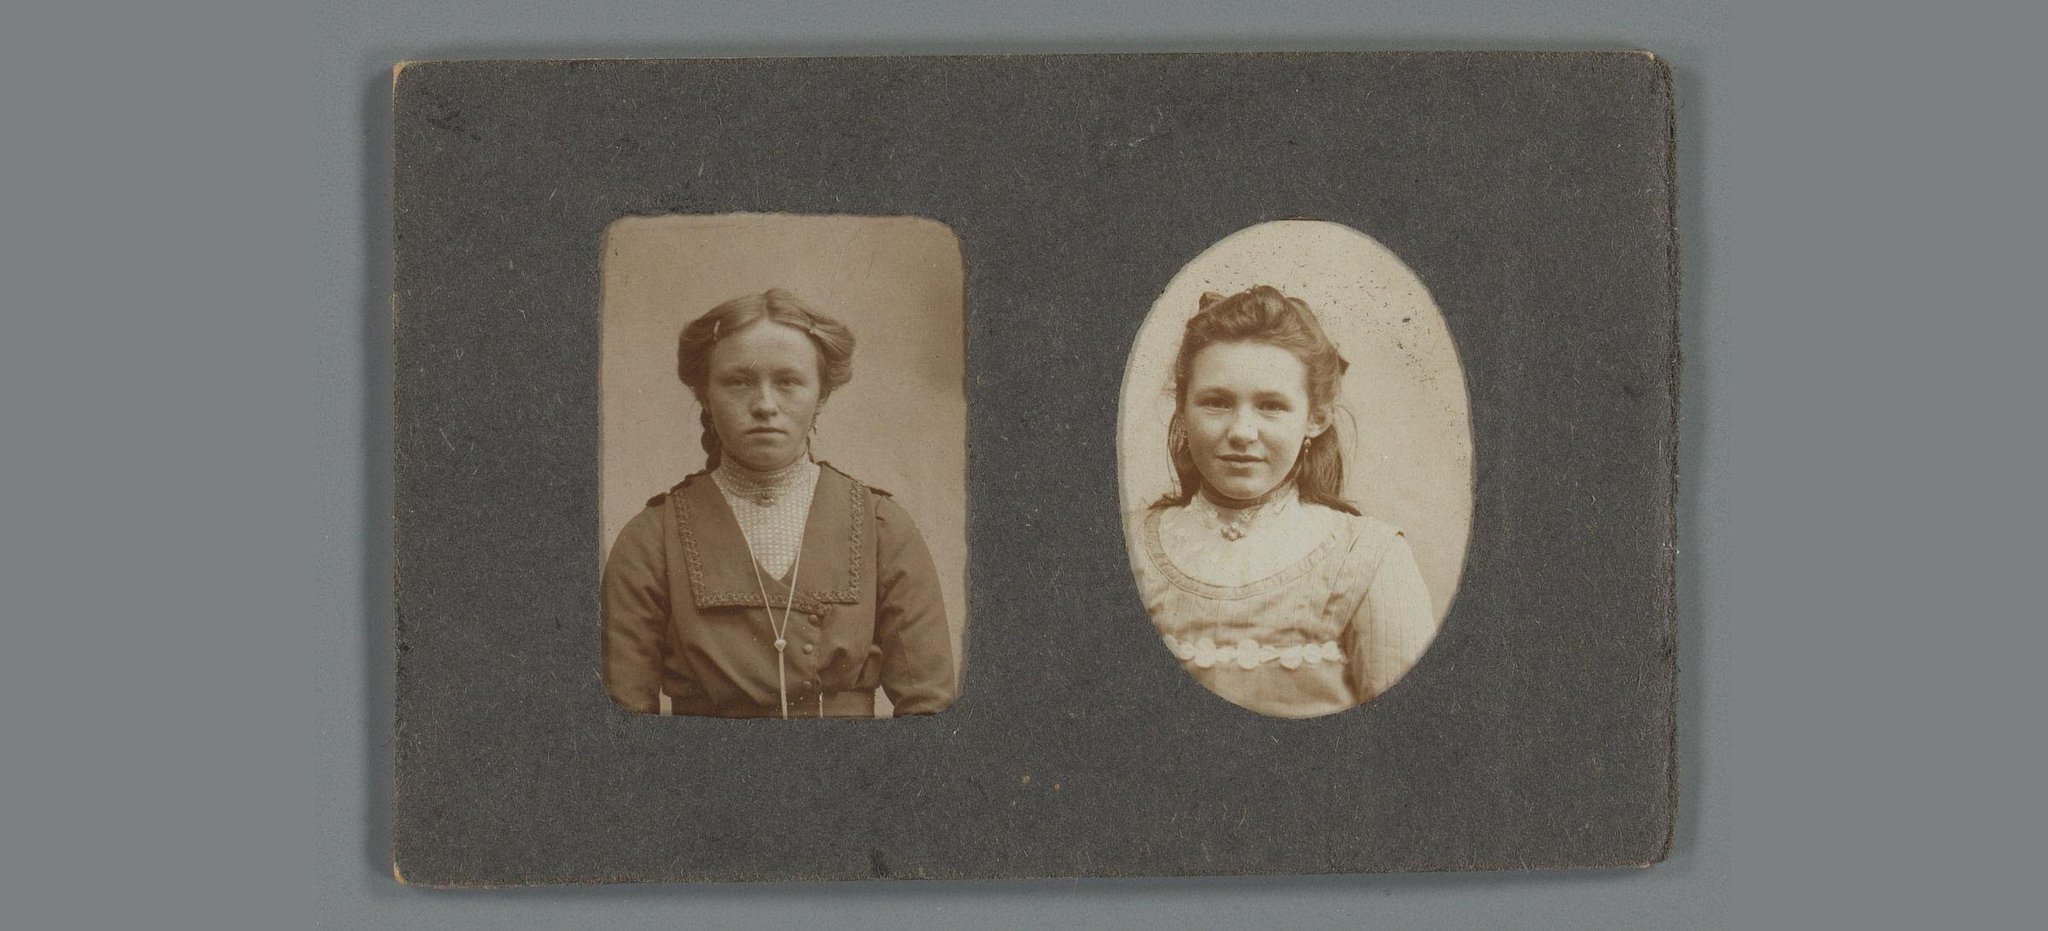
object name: photograph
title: Twee portretten van twee onbekende meisjes; gevat in een houder van karton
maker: Anonymous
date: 1880-1910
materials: paper, cardboard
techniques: collodion silver print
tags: historical persons not known by name - bb - woman, girl (child between toddler and youth)